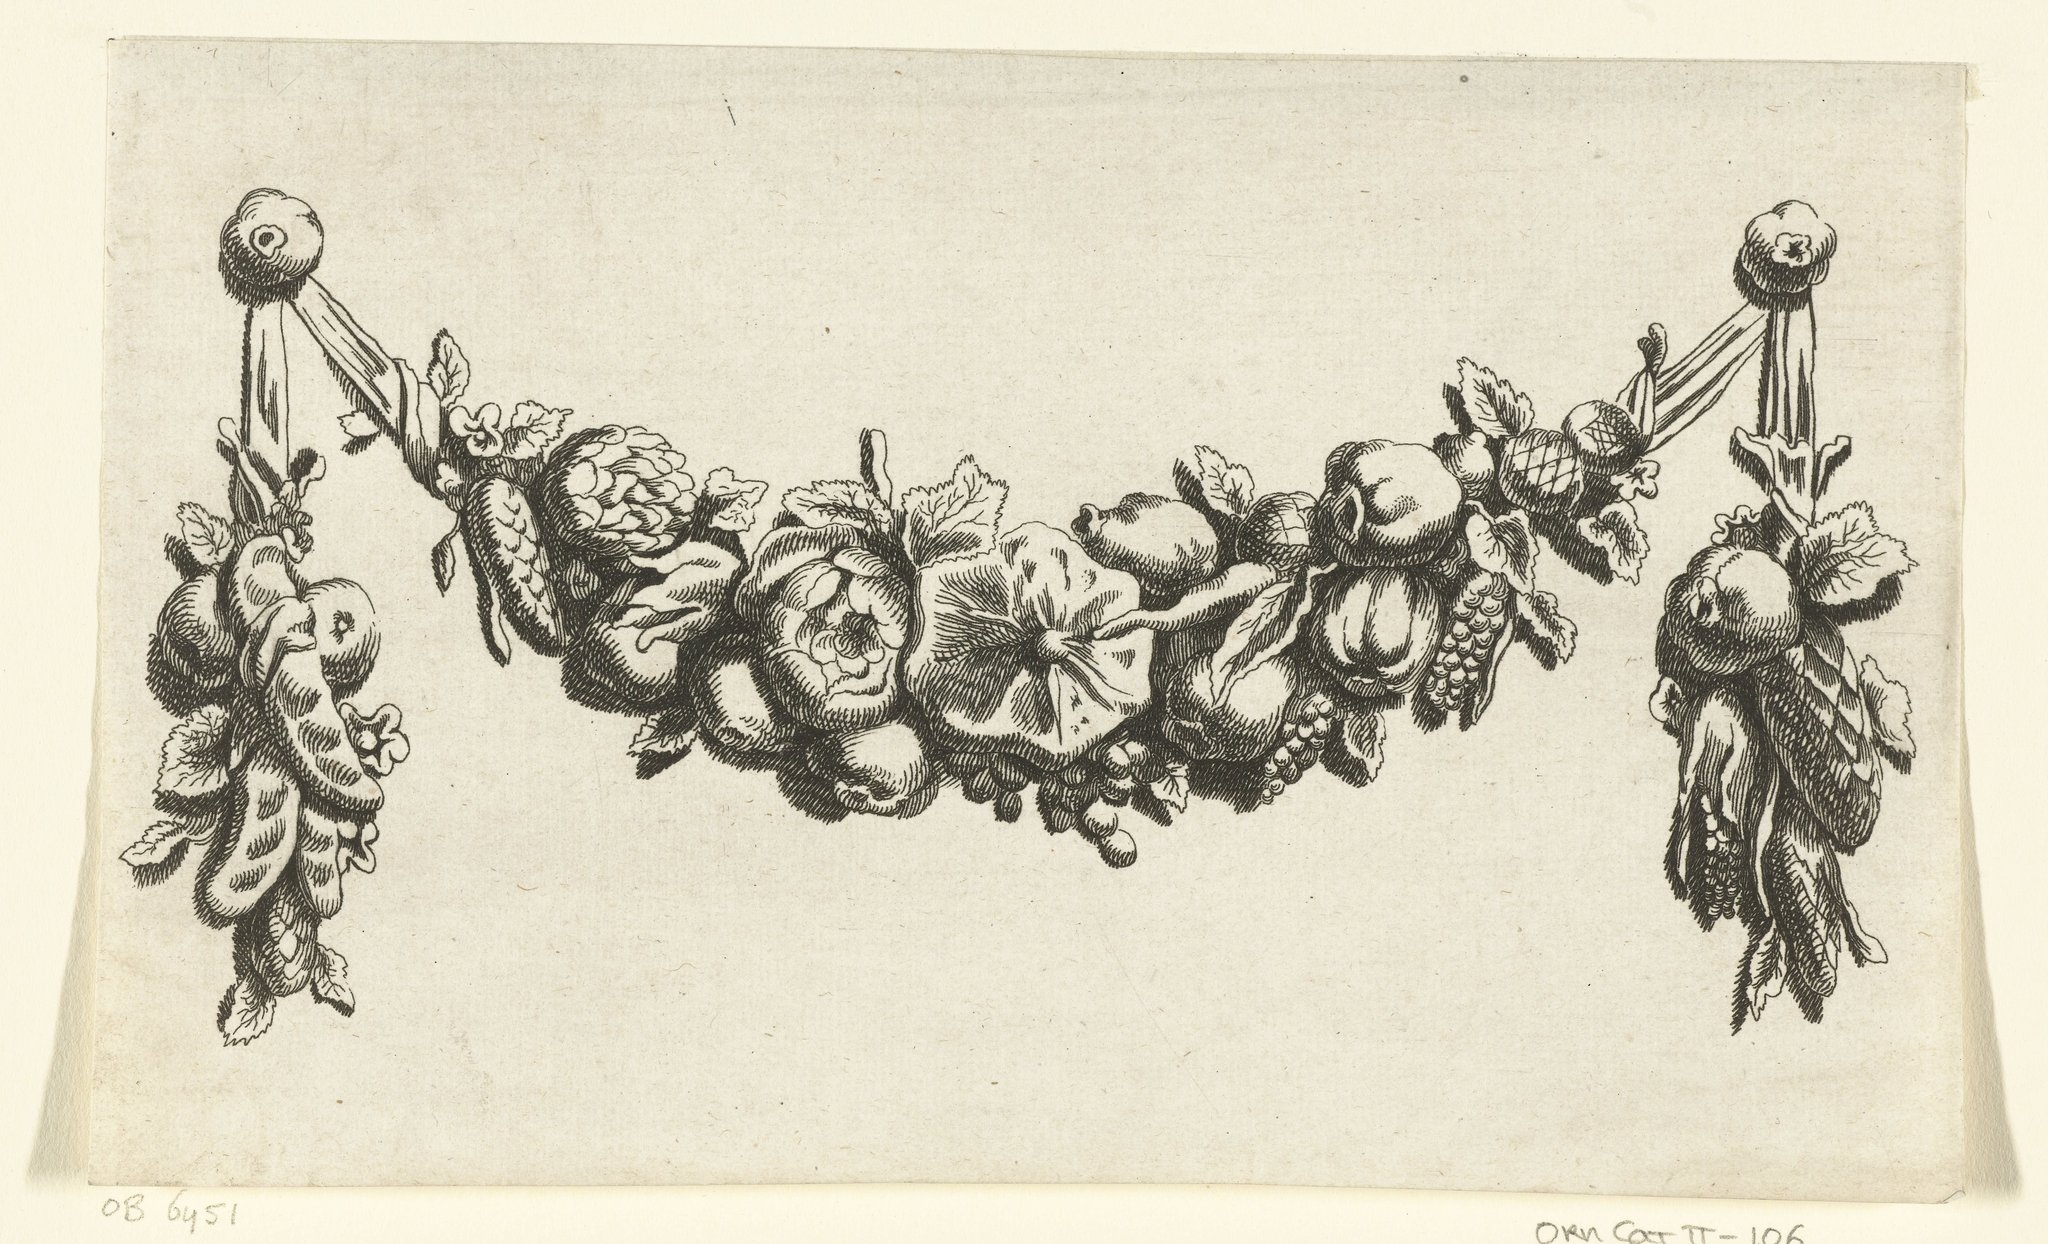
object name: print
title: Nieuwe Festonnen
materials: paper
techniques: etching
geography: amsterdam